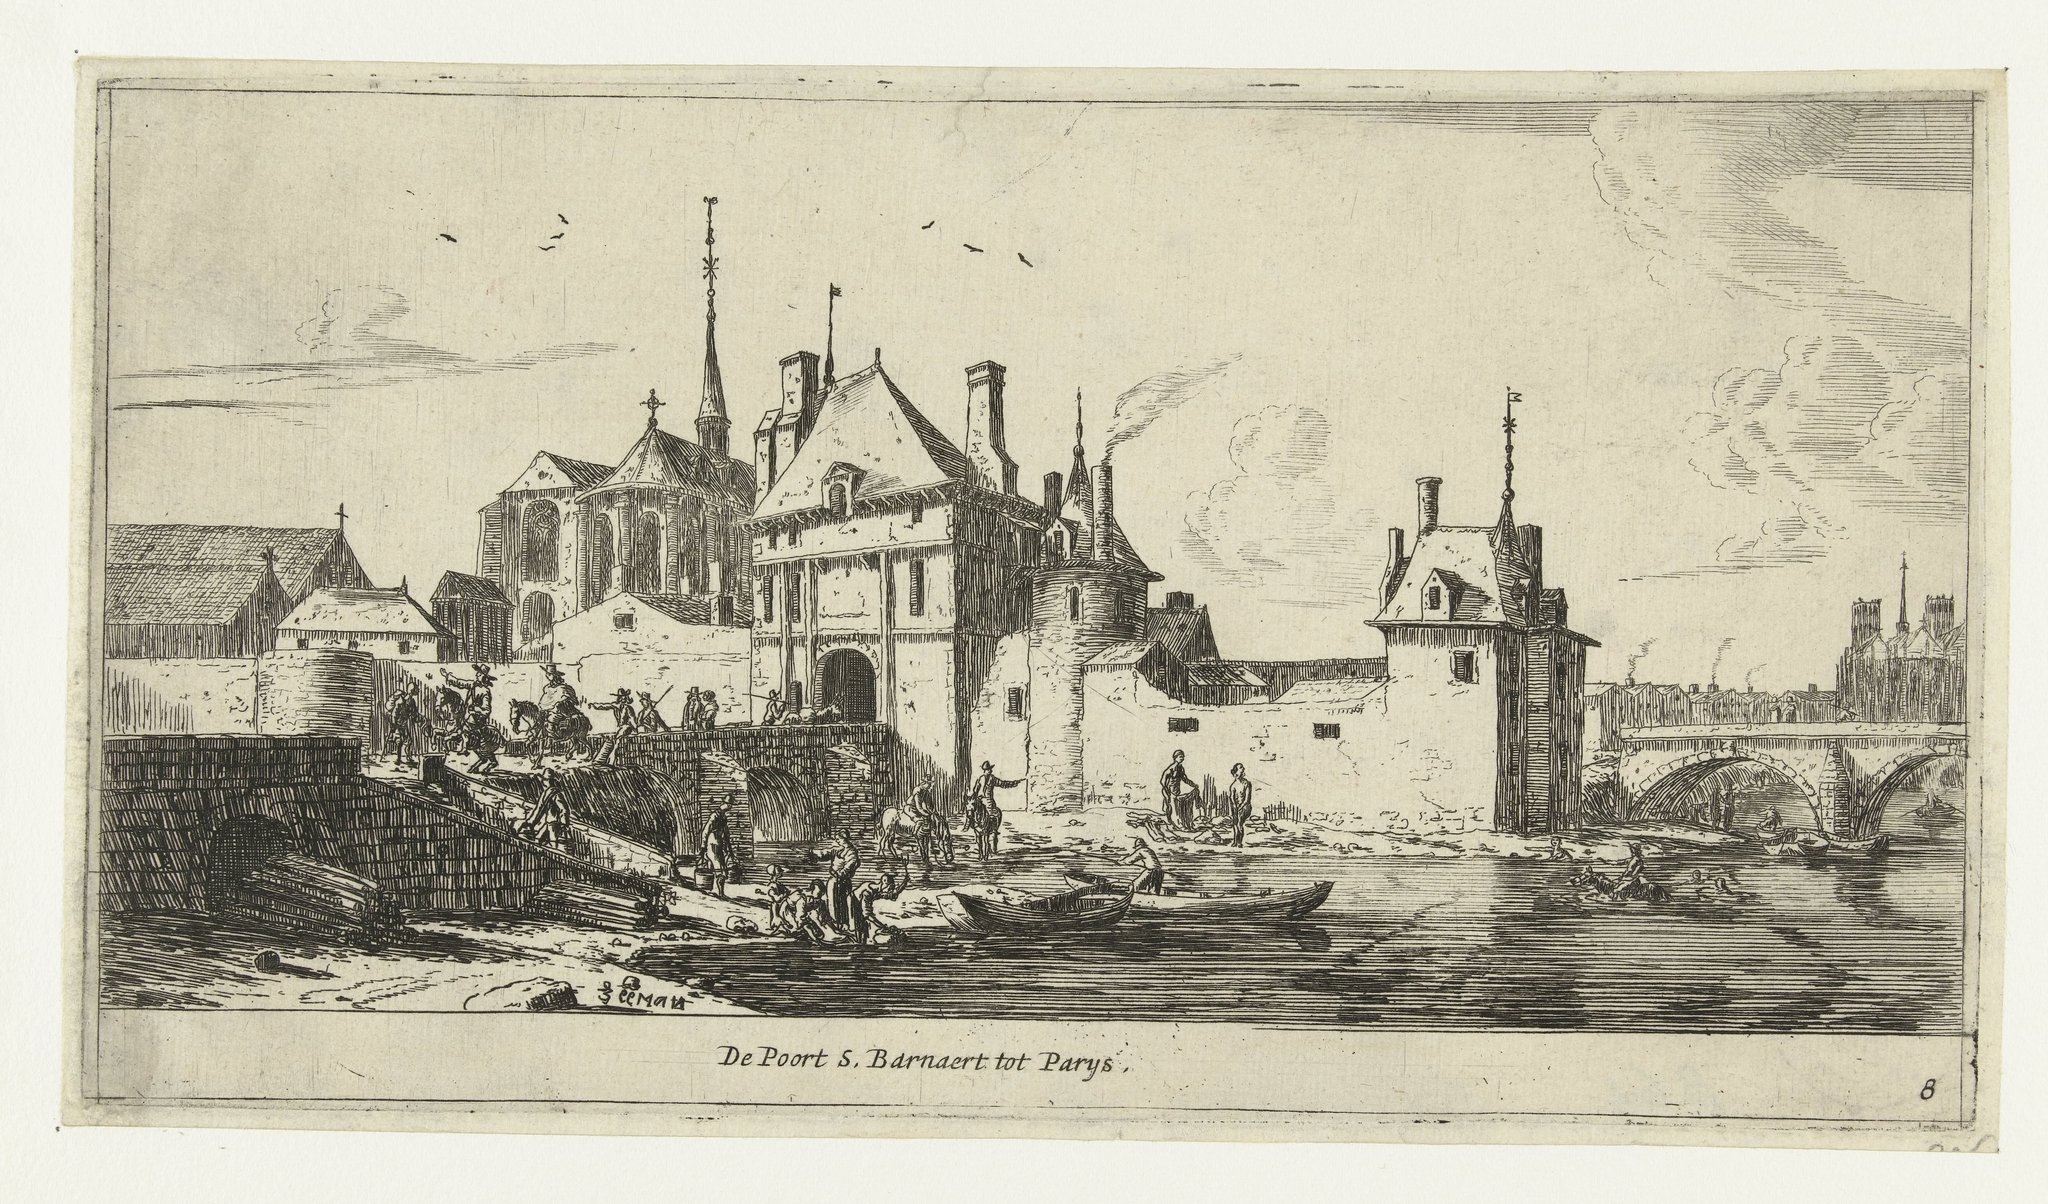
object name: print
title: Gezichten op Parijs en omgeving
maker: reinier nooms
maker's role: draughtsman, painter, print maker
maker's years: 1623-1664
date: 1656-1662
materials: paper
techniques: drypoint, etching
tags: gate, entrance, paris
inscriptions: collector's mark: Lugt 240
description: De stadspoort van St. Bernard te Parijs aan de Seine. Achter de stadsmuur een grote kerk zichtbaar.